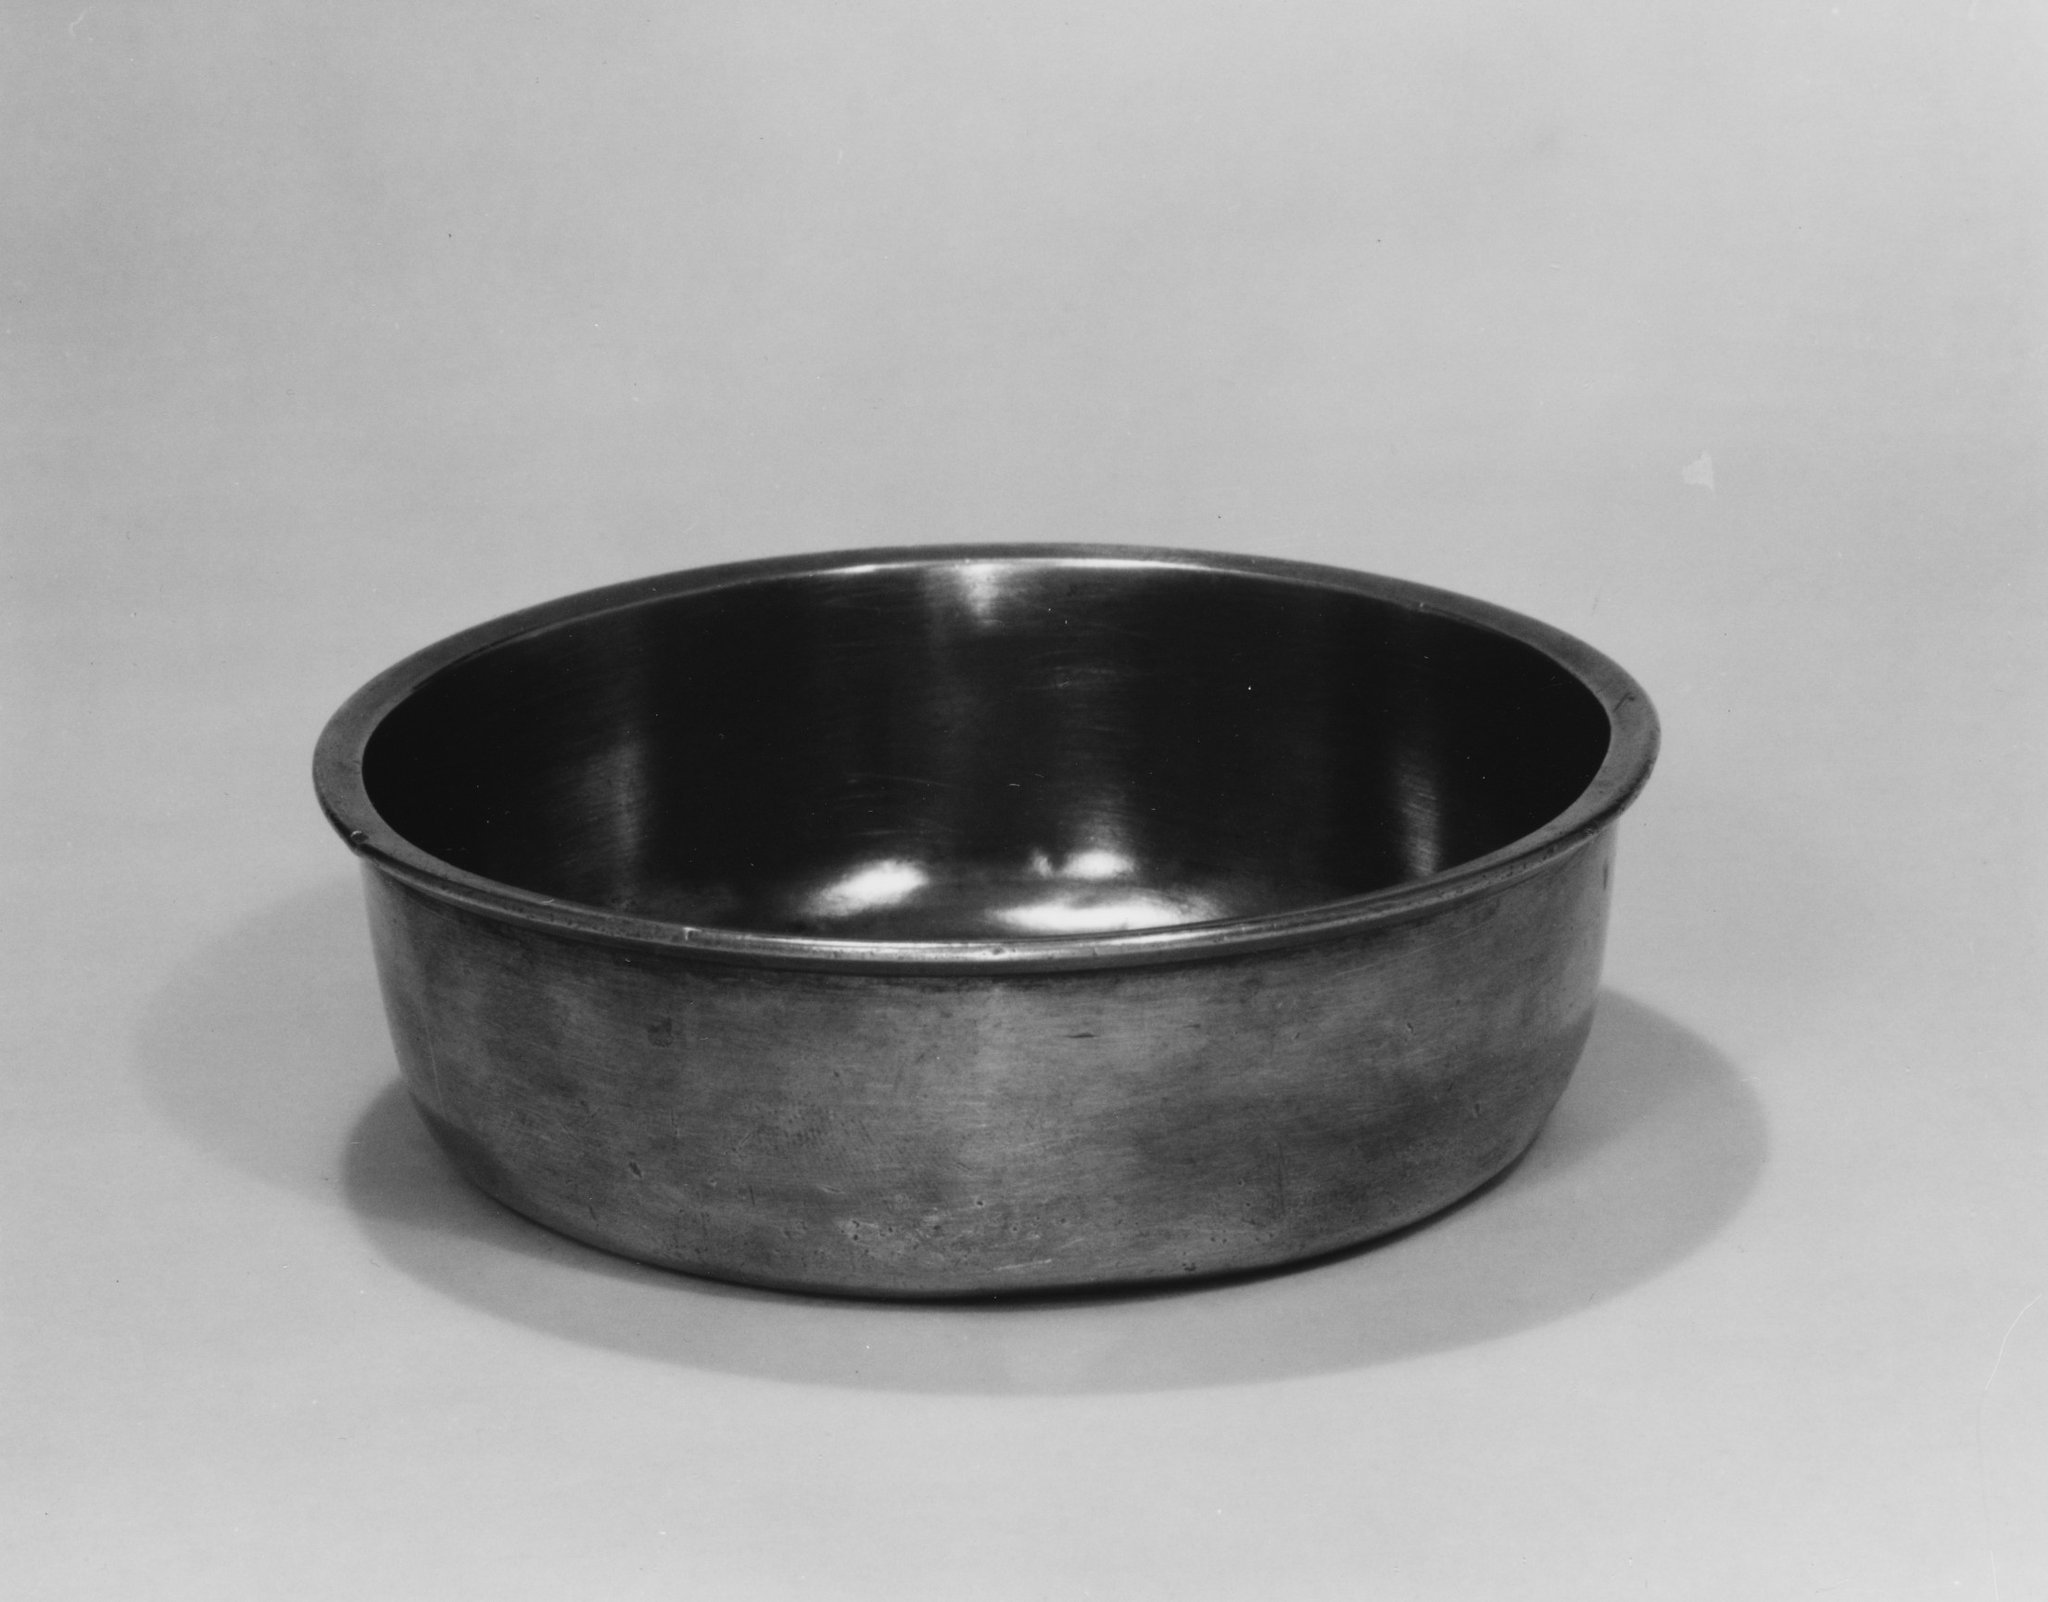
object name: basin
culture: american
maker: william bradford jr.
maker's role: maker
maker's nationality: american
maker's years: 1688-1758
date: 1719-1758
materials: pewter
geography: united states